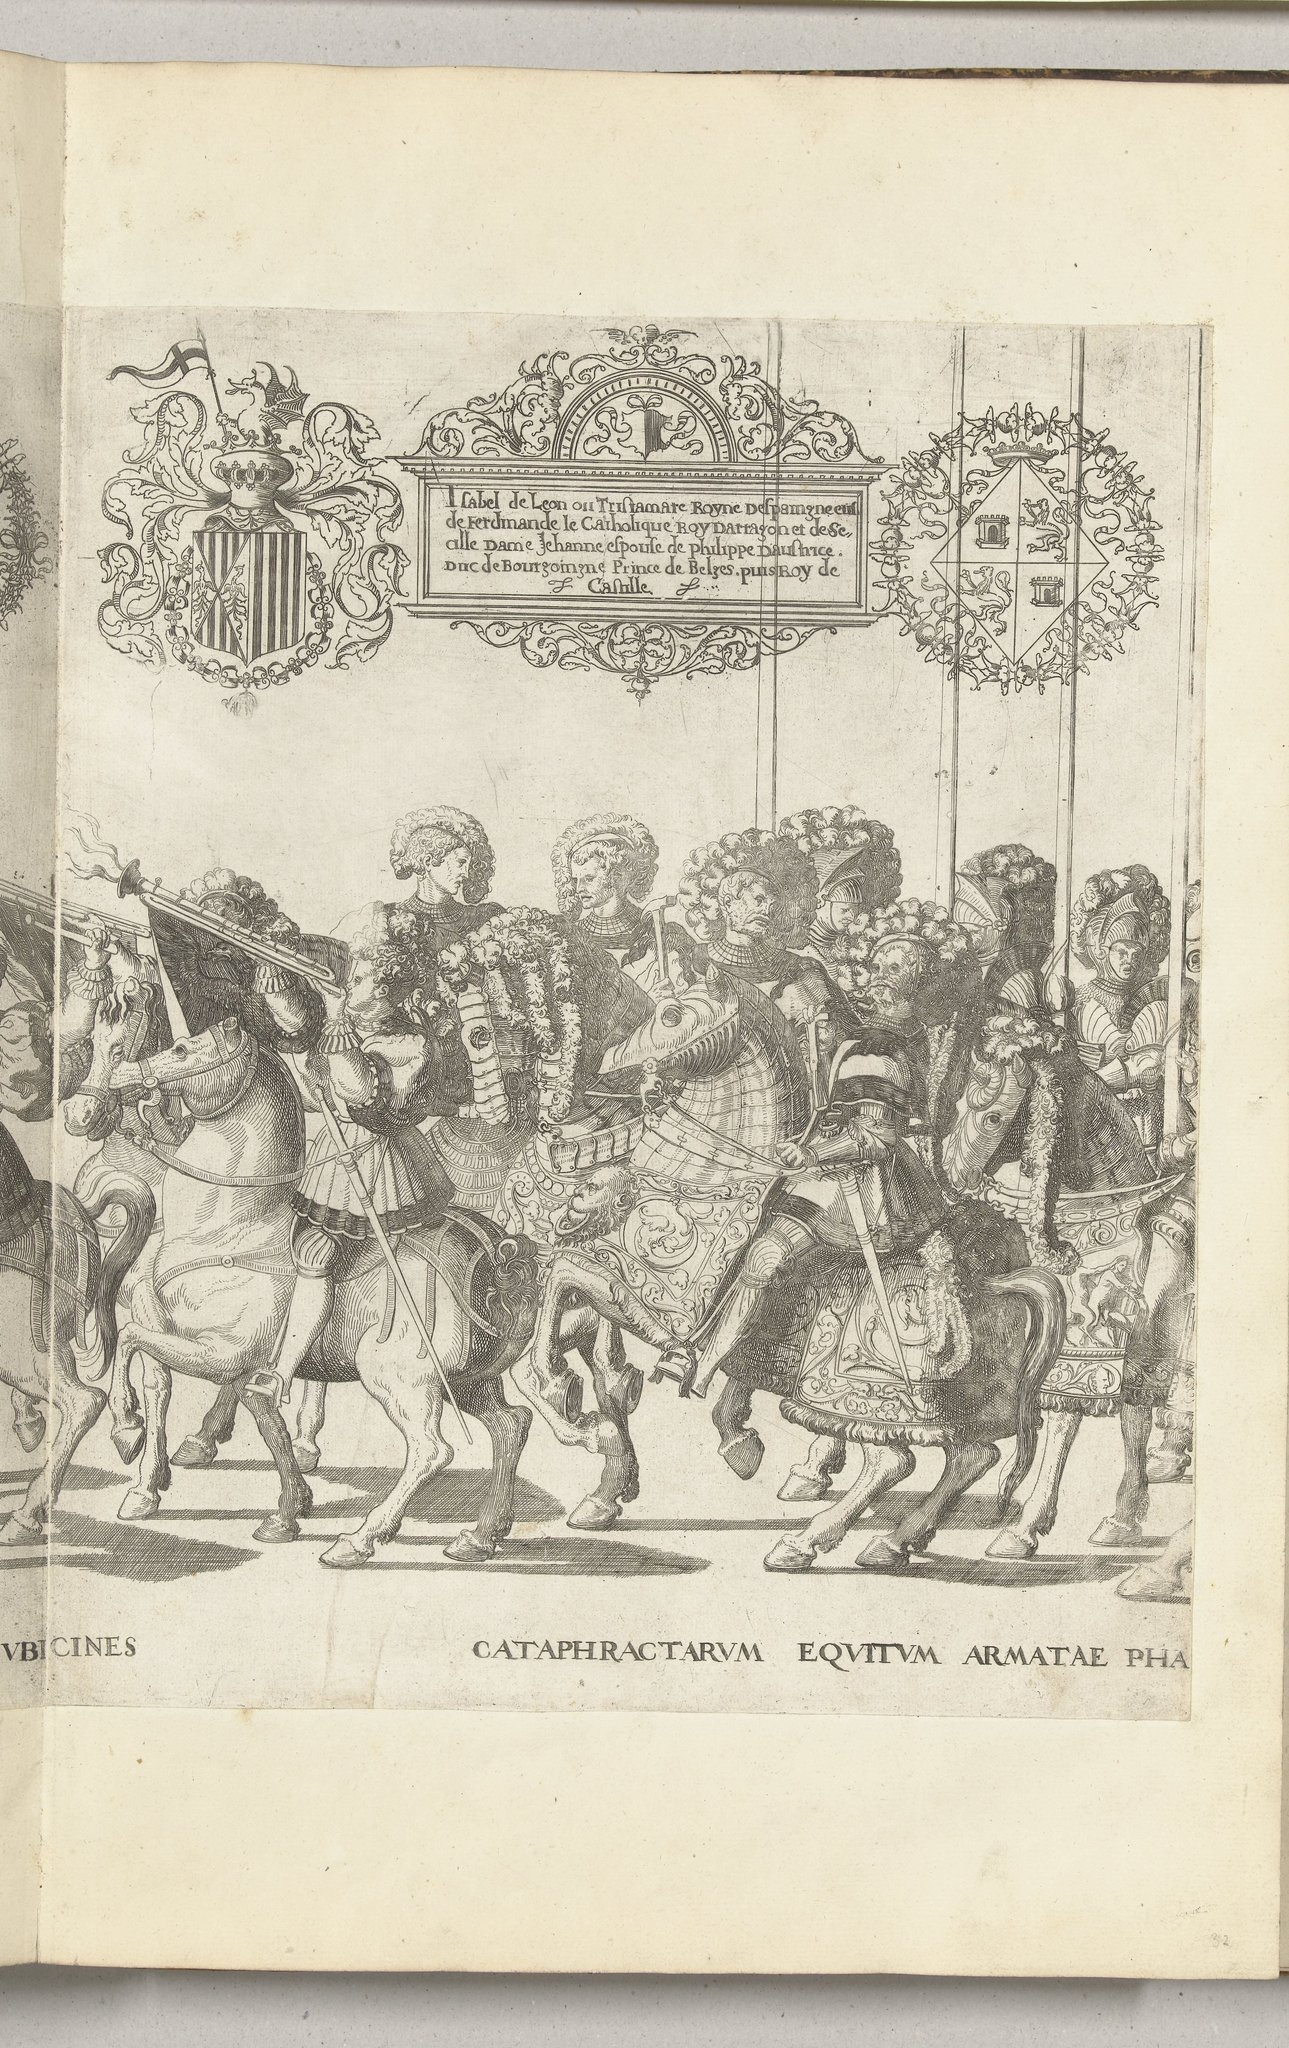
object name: print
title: Bazuinen en landsknechten, plaat [II]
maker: nicolaas hogenberg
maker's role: draughtsman, painter, print maker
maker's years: 1500-1539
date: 1530-1536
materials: paper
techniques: etching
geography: mechelen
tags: ghent, charles v (holy roman emperor and king of spain), rome, festivities (+ parade, pageant, cavalcade ~ festive activities)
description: Prent in het album waarin zijn ingeplakt de 40 platen die achterelkaar samen het fries vormen van de optocht van Karel V met de paus Clemens VII te Bologna na zijn kroning tot keizer, 24 februari 1530.